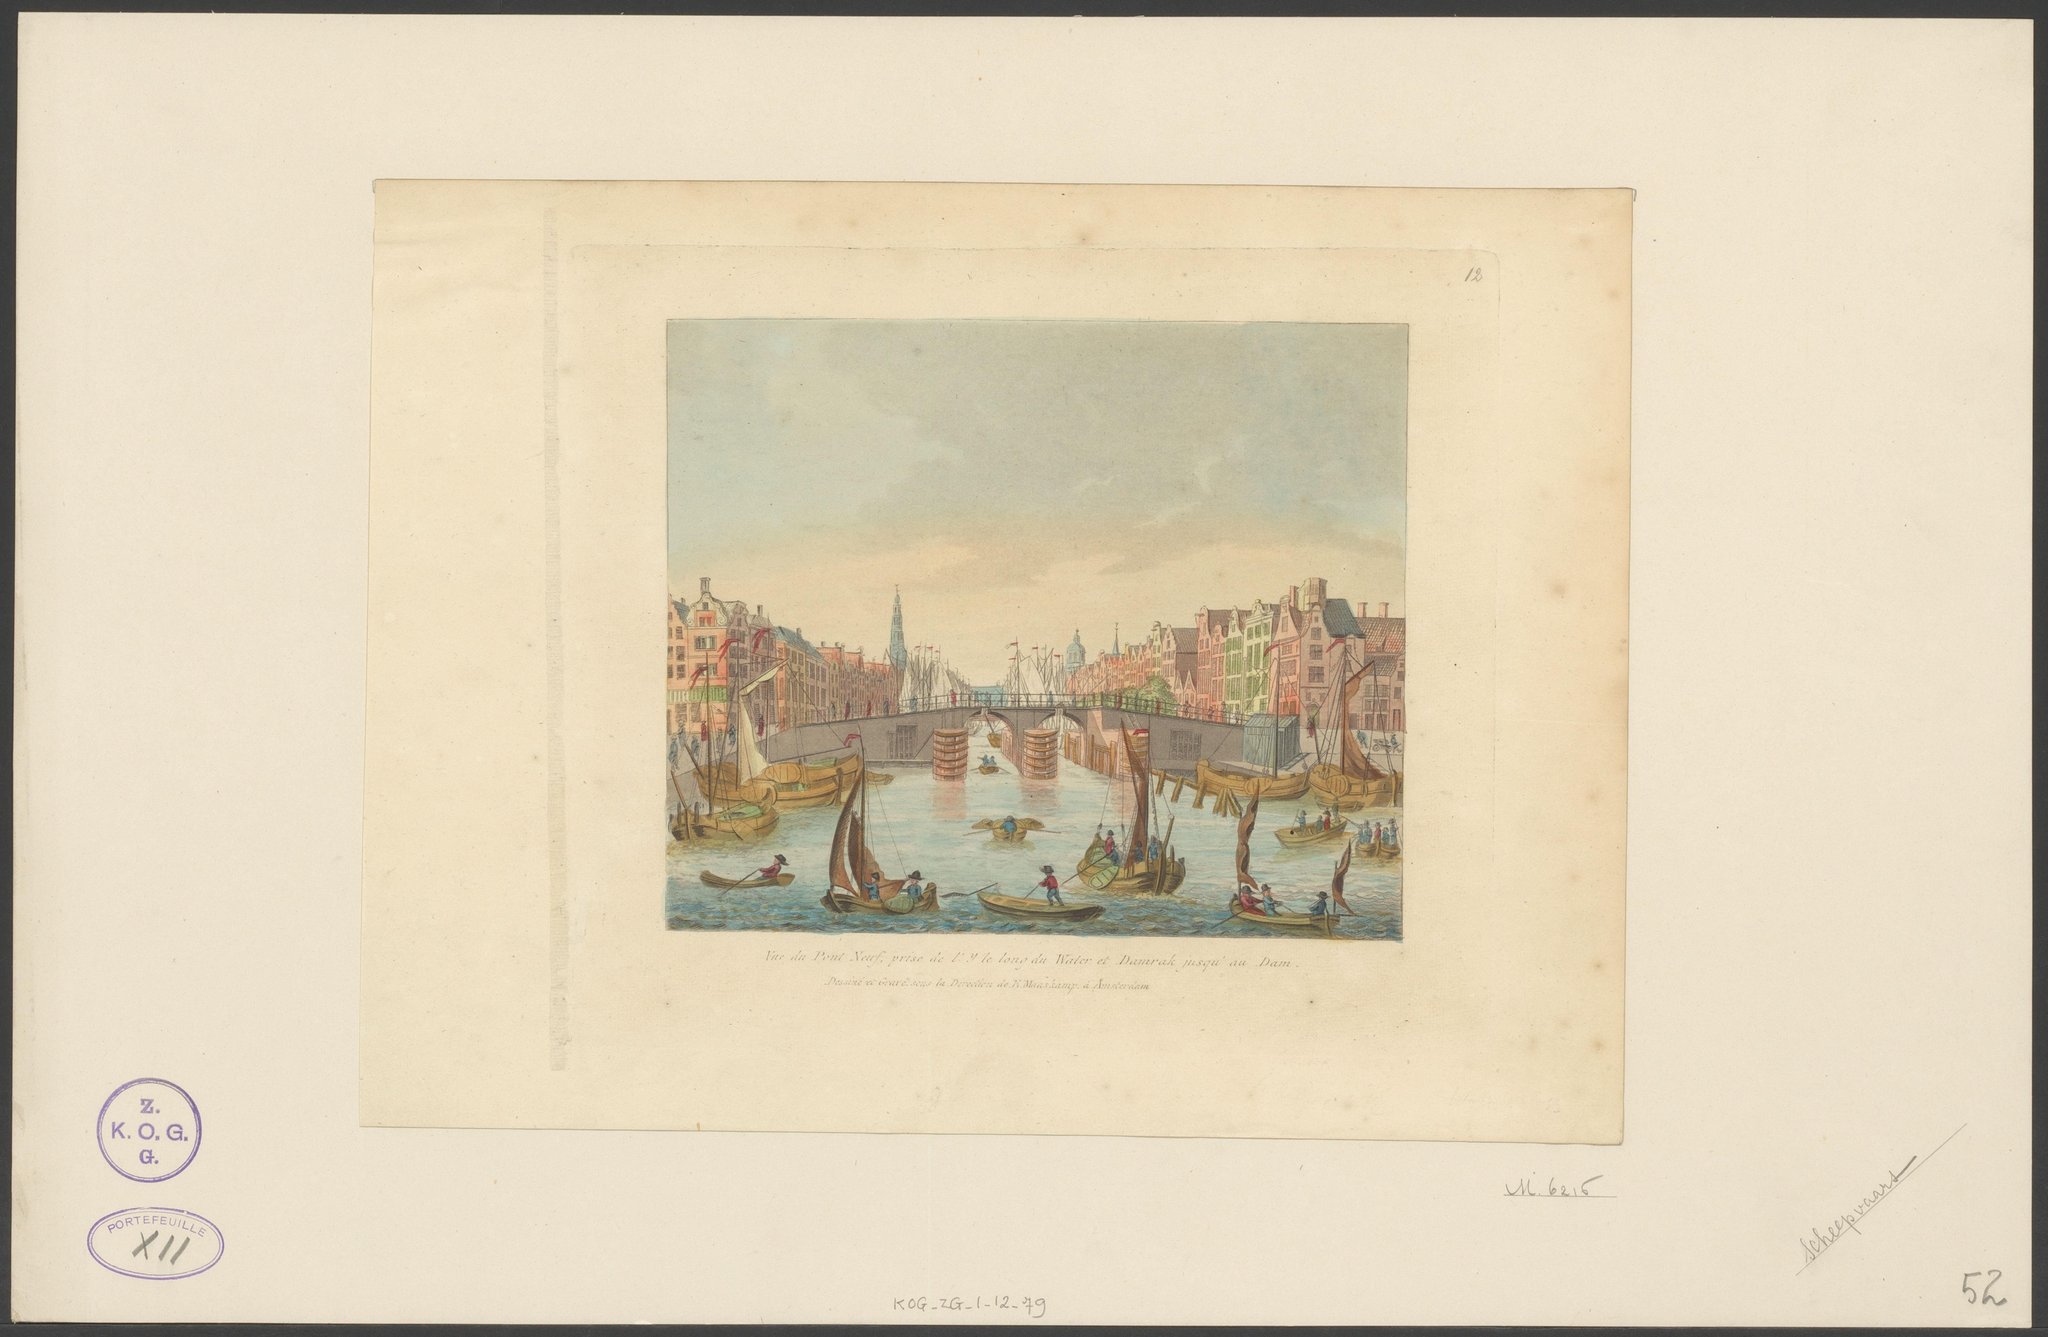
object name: print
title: Vue du Pont Neuf, prise de l'IJ le long du Water et Damrak jusqu' au Dam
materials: paper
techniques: aquatint, etching, hand coloring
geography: amsterdam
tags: rowing-boat, canoe, etc., geographical names of countries, regions, mountains, rivers, etc.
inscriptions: collector's mark: Lugt 1641, stamp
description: Tweede staat gebruikt in: Nouvelle statistique historique d'Amsterdam, ou Le guide du voyageur en cette ville. Amsterdam: Evert Maaskamp, 1817, dl. 1, na p. 132.